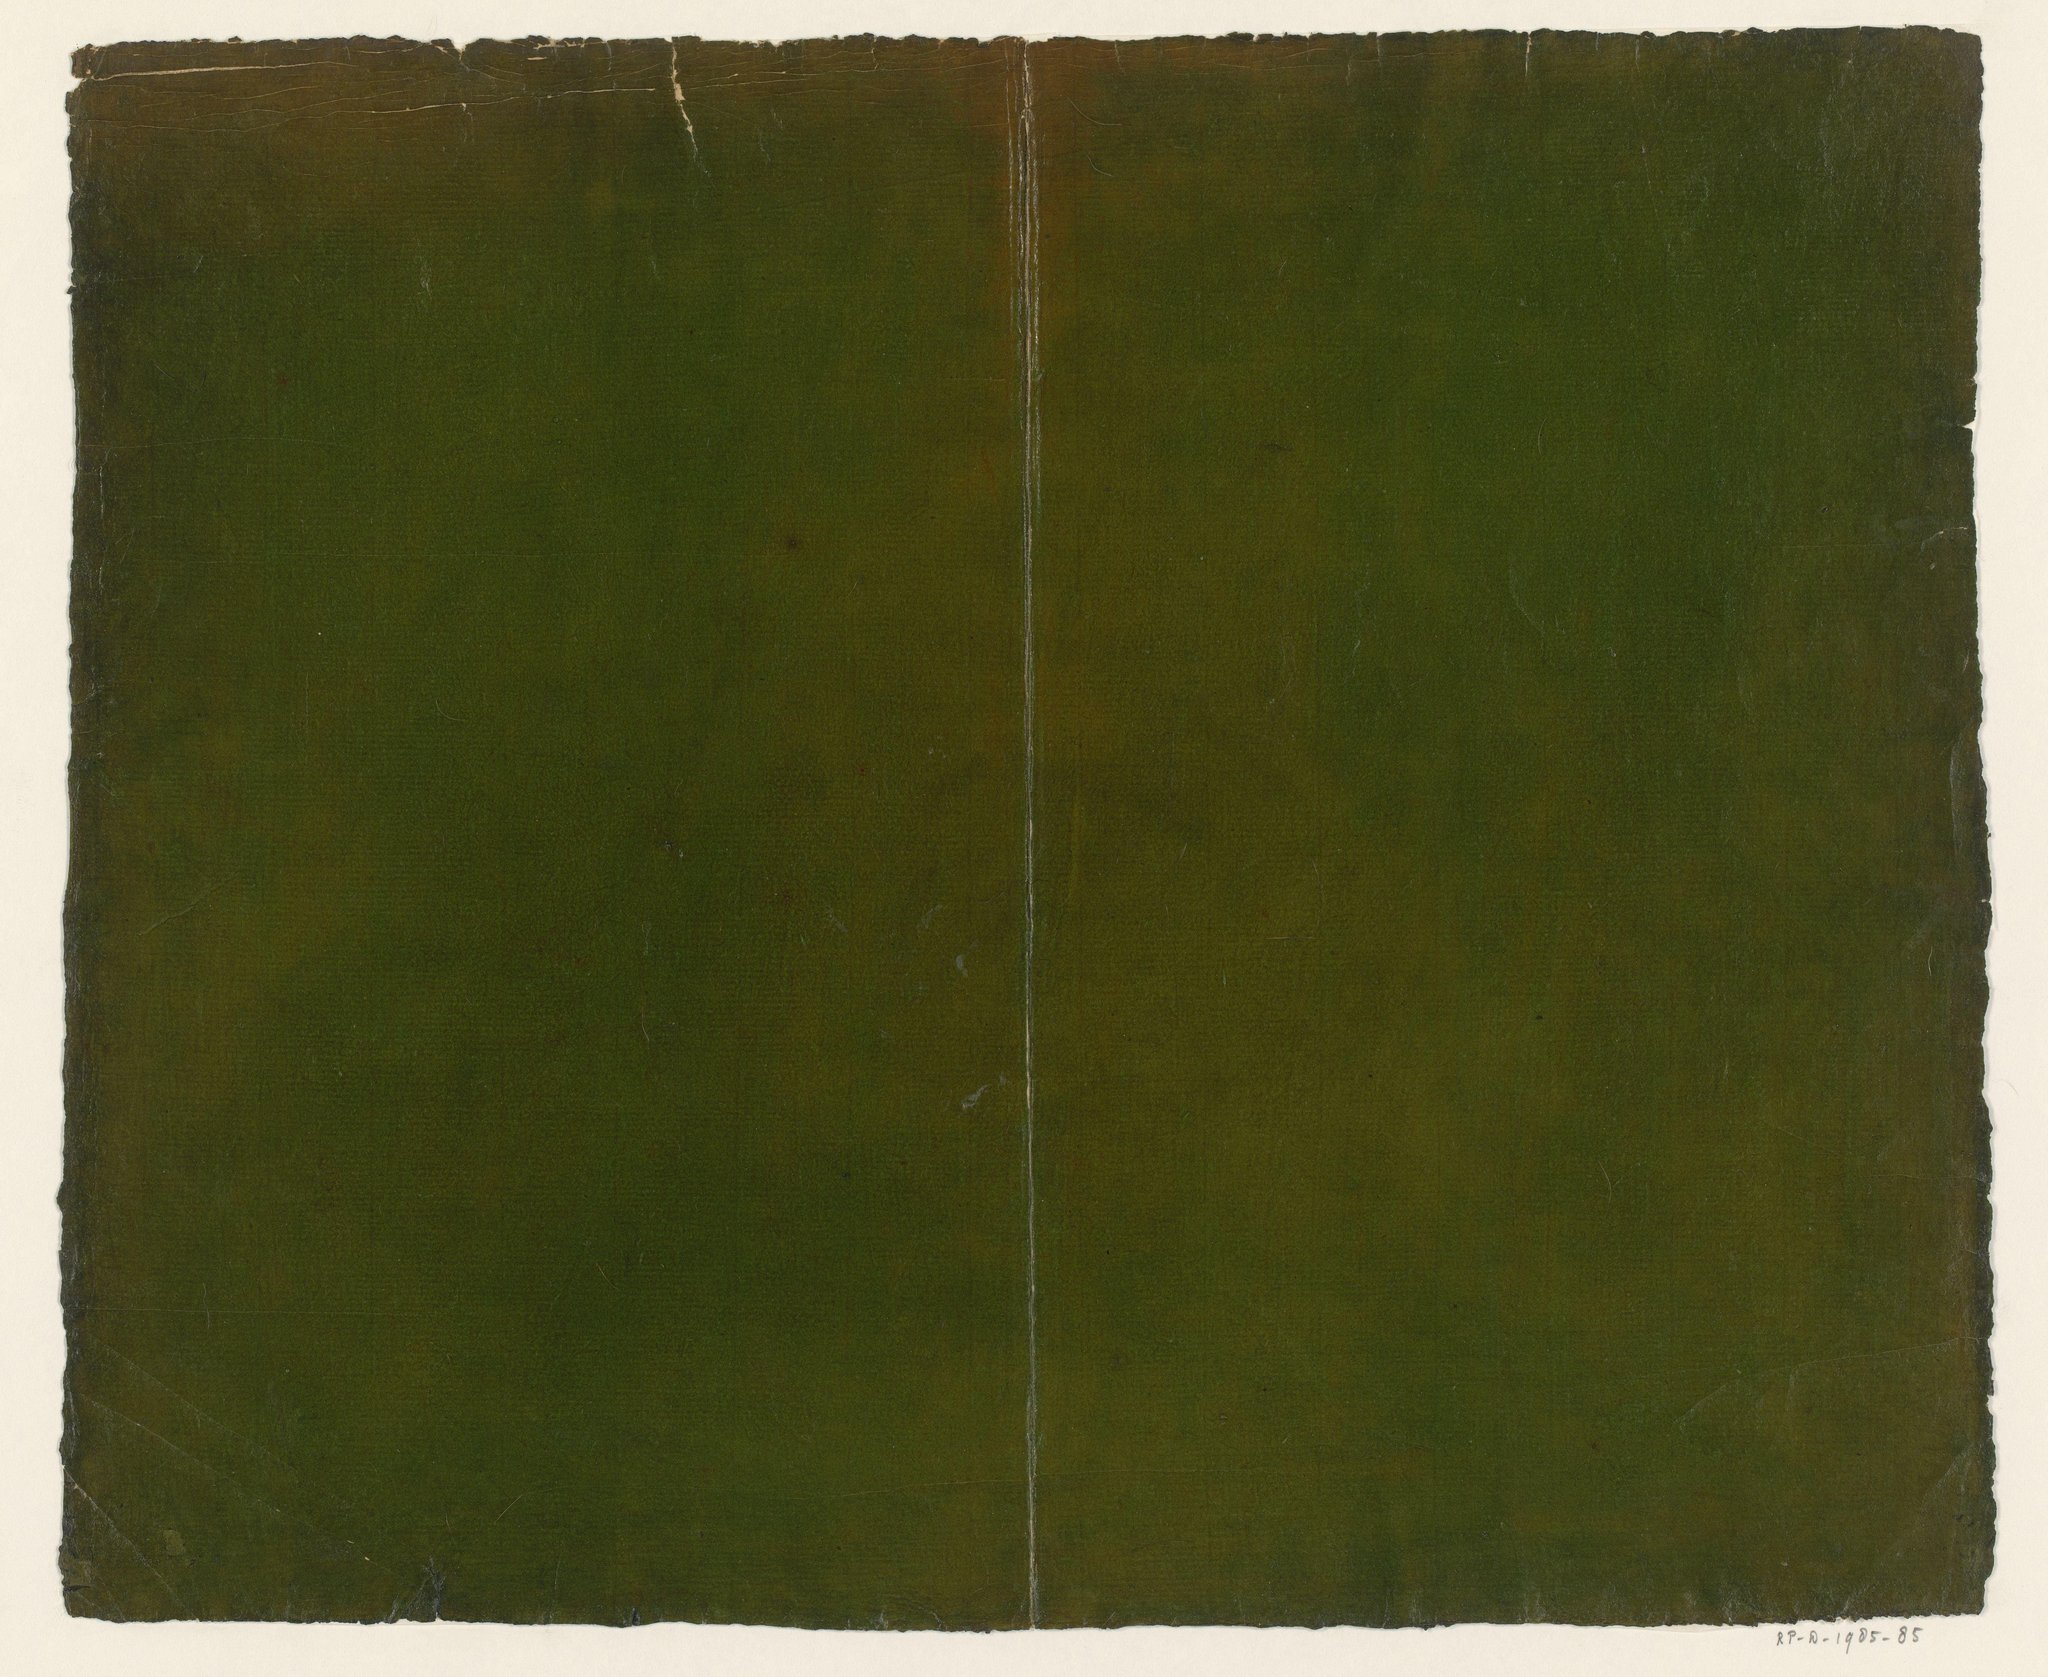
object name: decorated paper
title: Effen olijfgroen papier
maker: Anonymous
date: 1800-1950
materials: lacquer, paint, paper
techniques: hand coloring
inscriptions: collector's mark: Lugt 2760, collector's mark: Lugt 2228